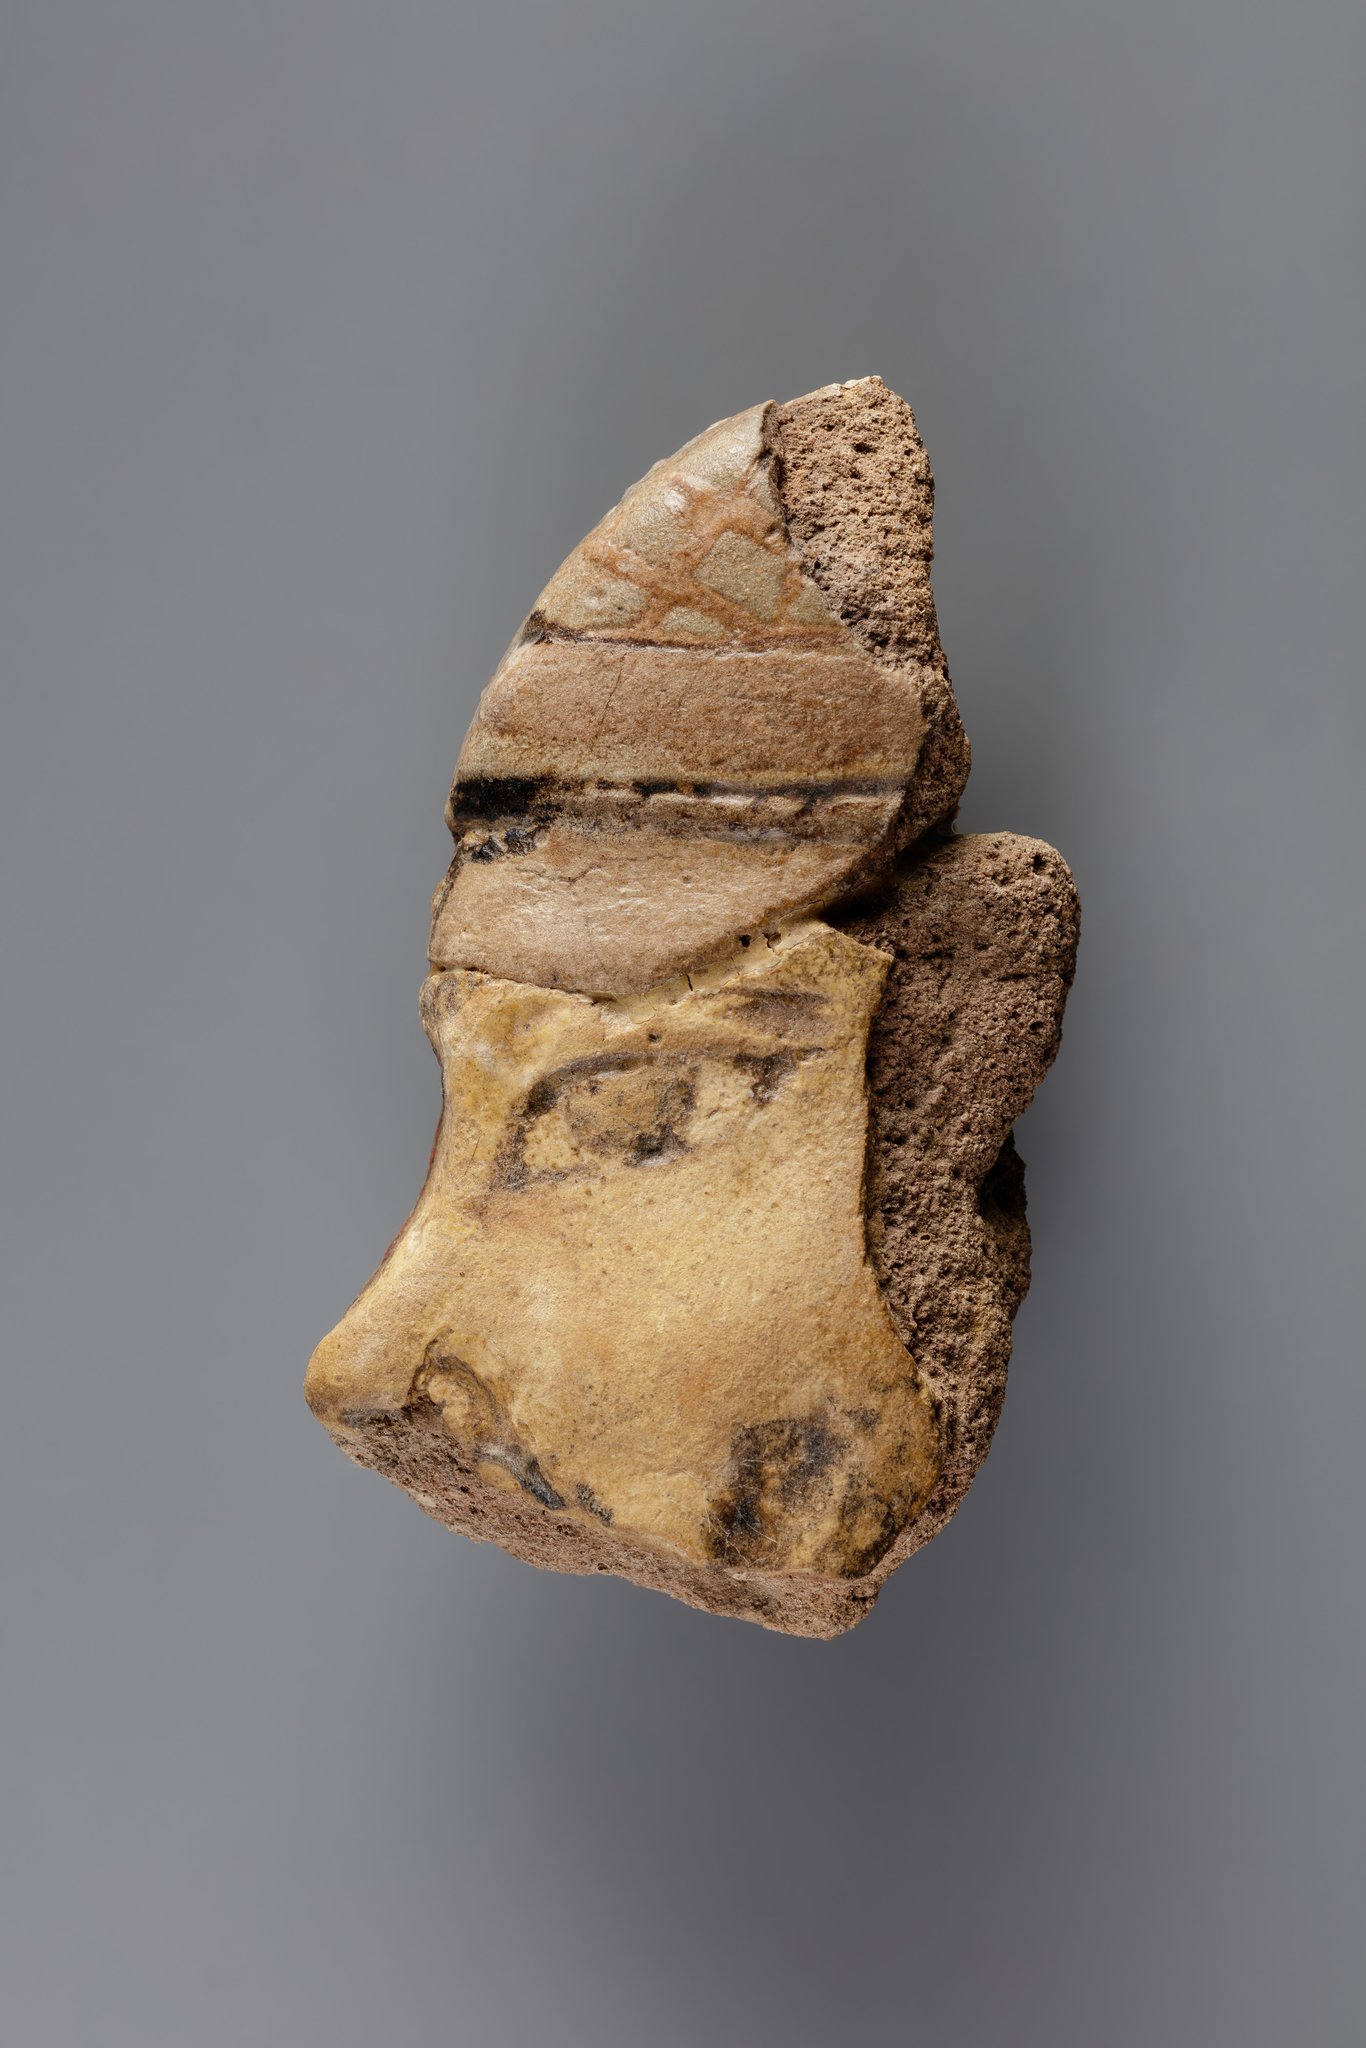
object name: tile inlay, palace of ramesses ii, foreigner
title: Tile with a fragment from a head of a Mesopotamian captive from the palace of Ramesses II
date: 1279-1213 BCE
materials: faience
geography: egypt